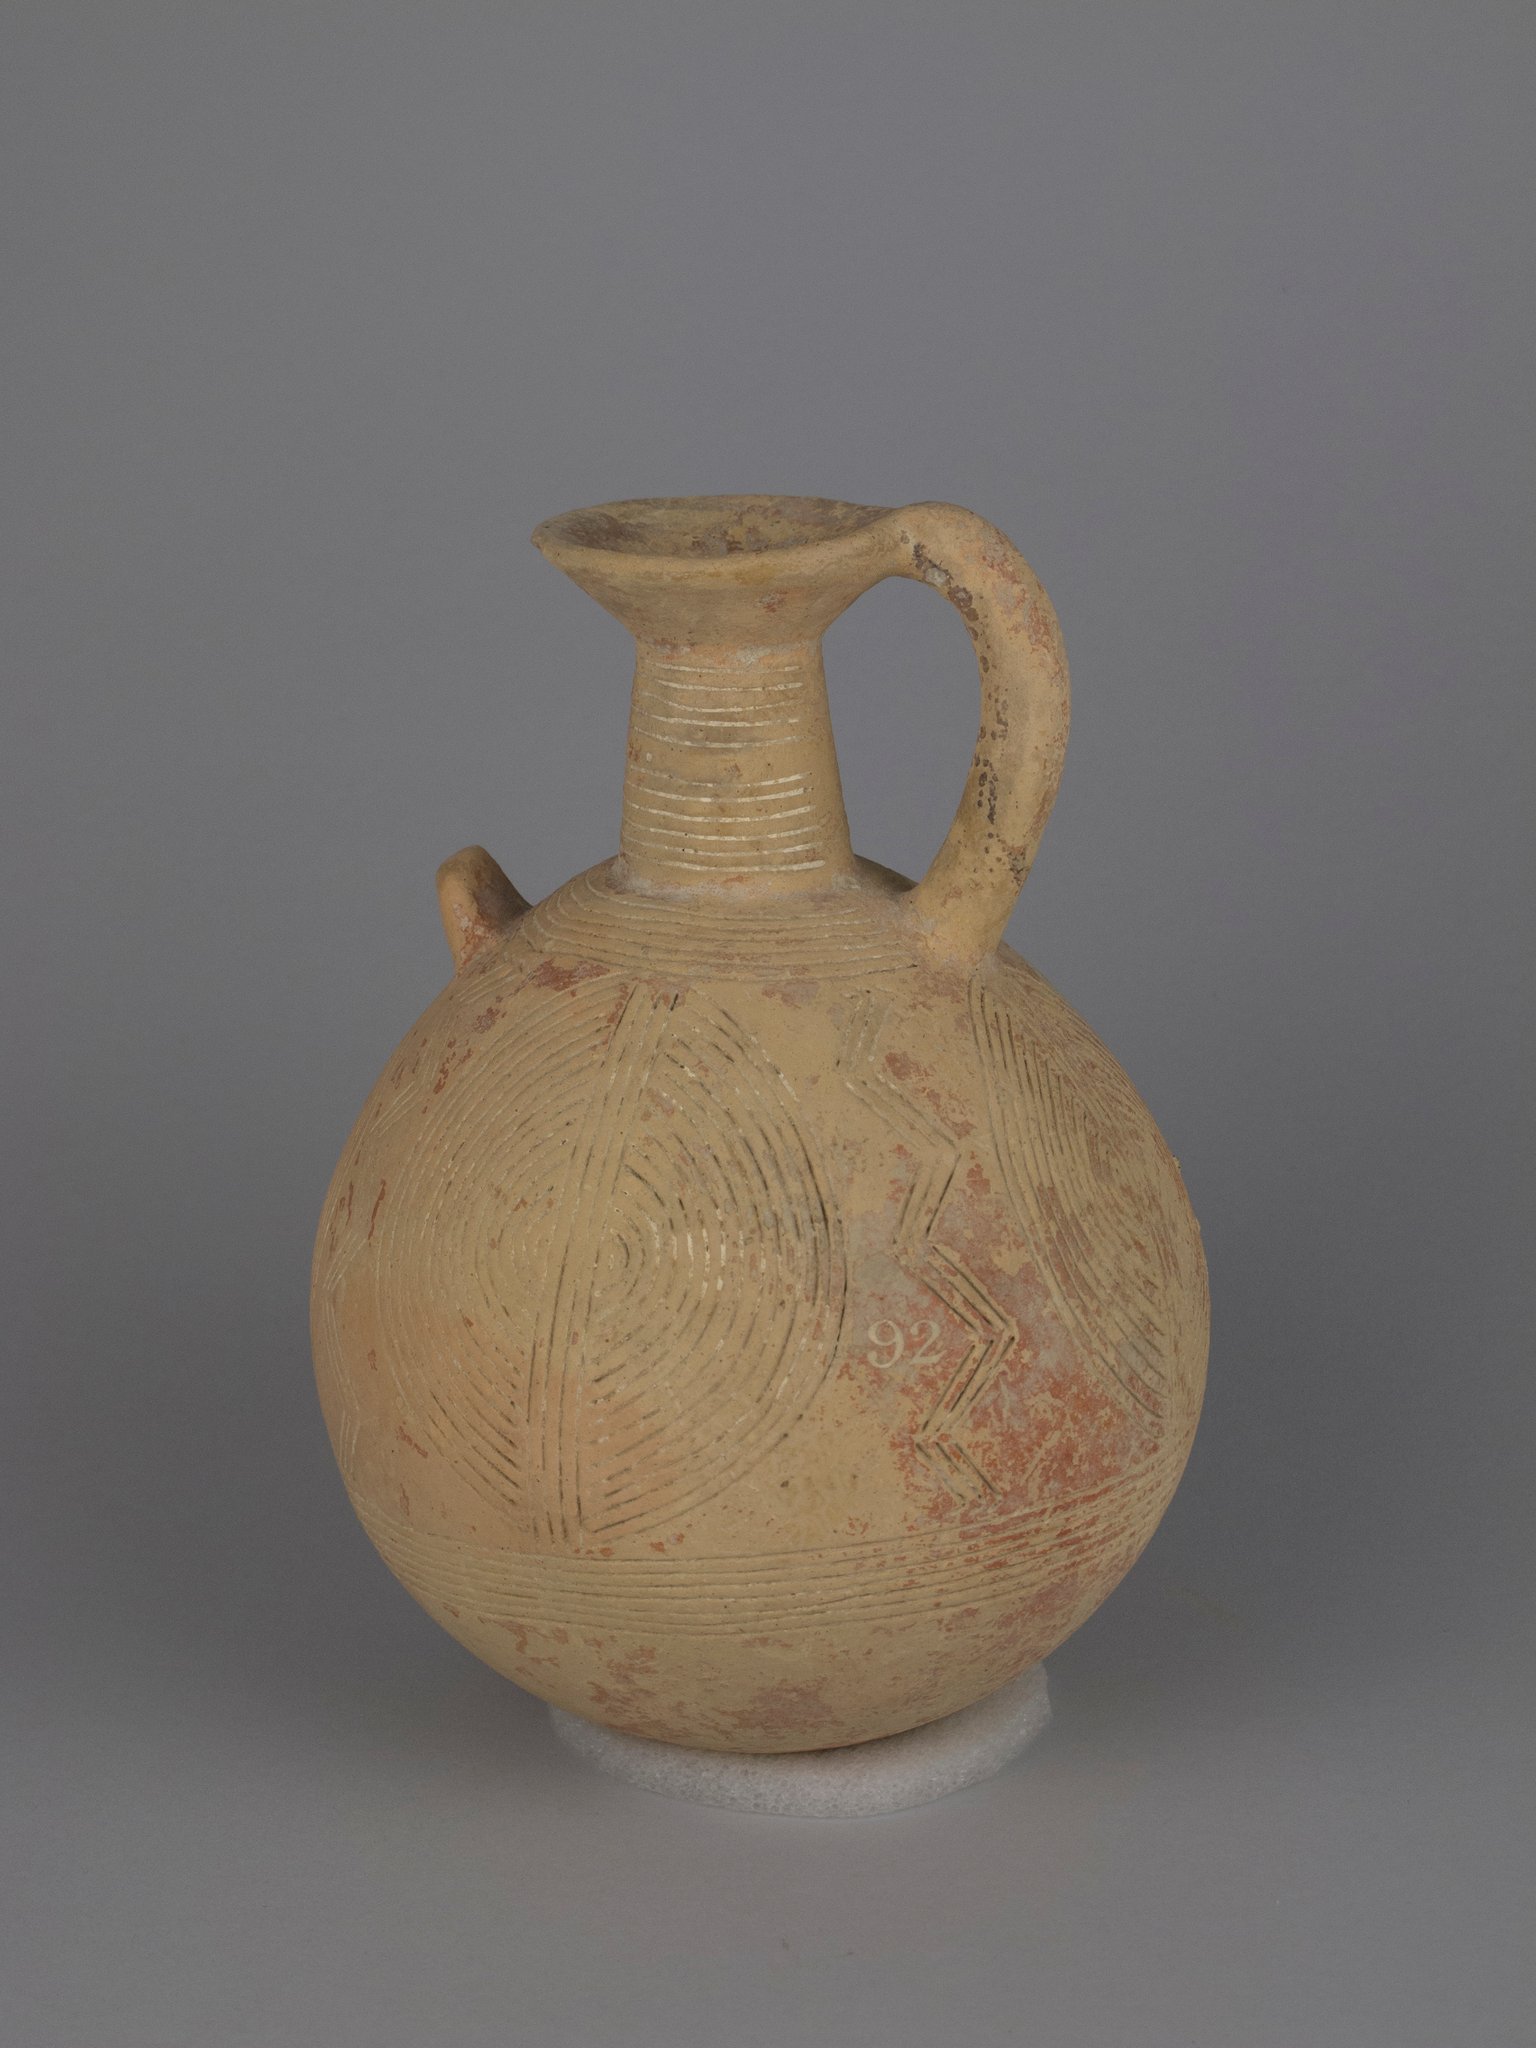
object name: jug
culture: cypriot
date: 2500-1900 BCE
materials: terracotta